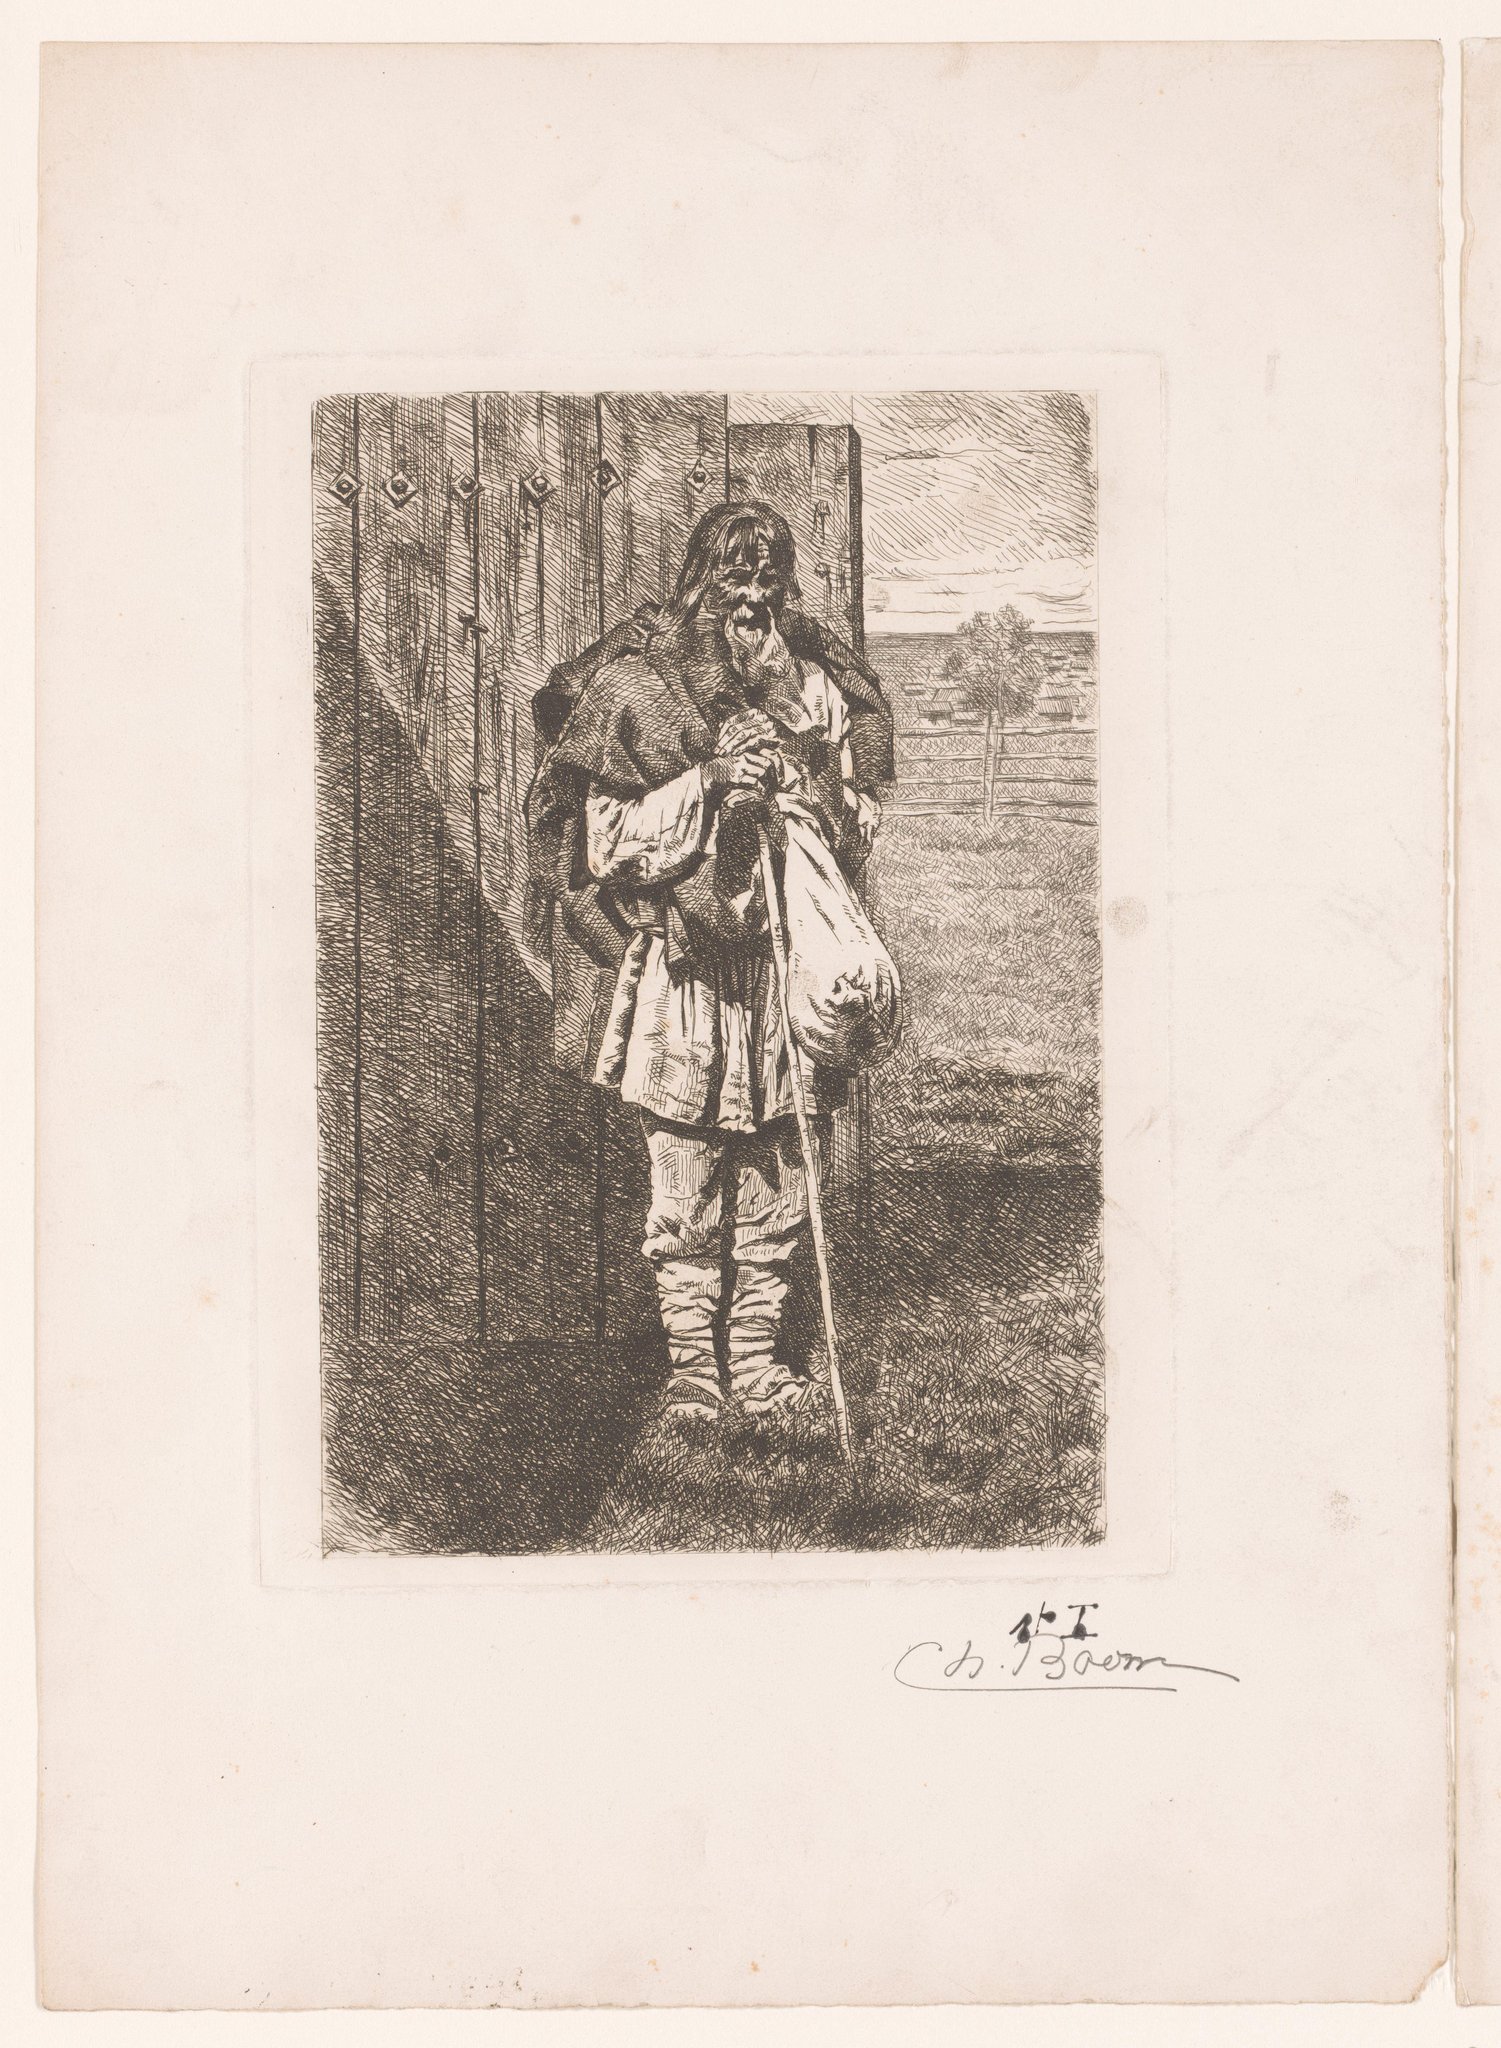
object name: print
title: Oude man met plunjezak voor een schutting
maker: charles boom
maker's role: print maker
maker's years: 1858-1939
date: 1868-1909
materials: paper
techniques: etching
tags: old man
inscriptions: annotation: ‘st I’